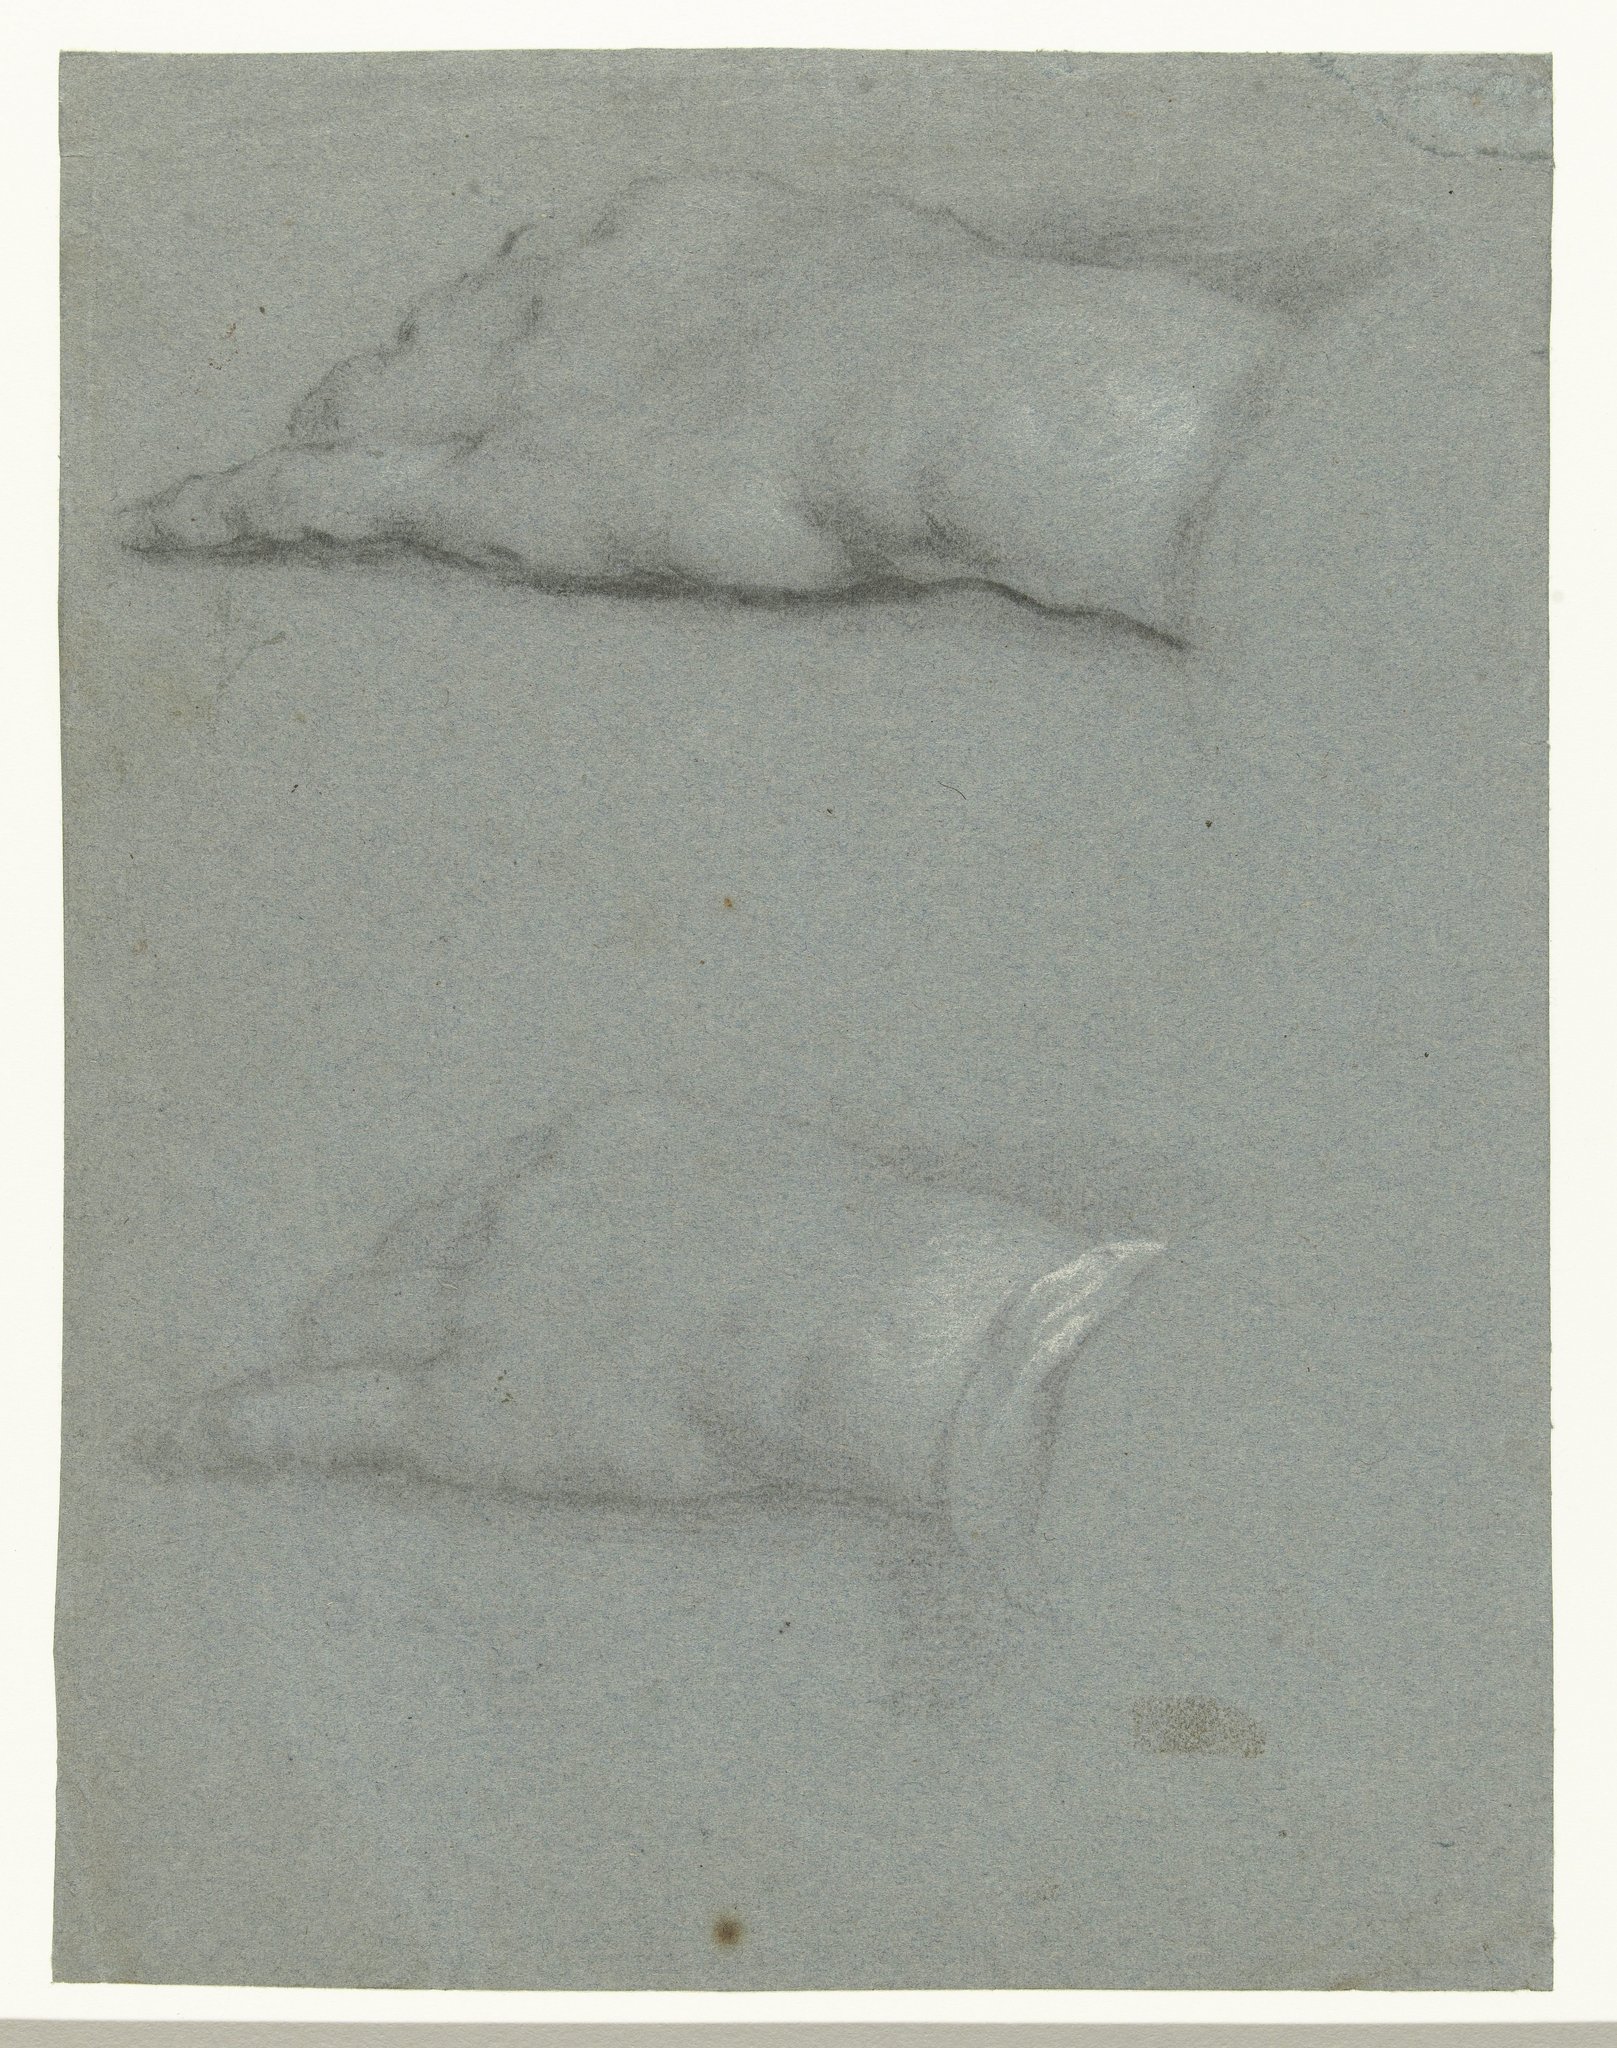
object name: drawing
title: Twee studies van een linkerhand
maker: anthony van dyck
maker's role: draughtsman, painter, print maker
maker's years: 1599-1641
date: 1610-1641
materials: chalk, paper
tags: hand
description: Afkomstig uit een tekeningenalbum met onder andere figuur- en handstudies van of naar Caspar en Constantijn Netscher (BI-1894-3720). Tekening bevond zich oorspronkelijk op f. 36.